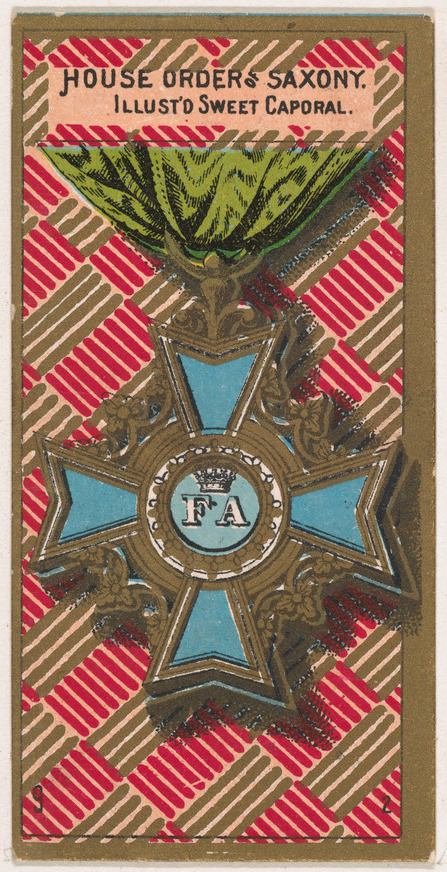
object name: print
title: House Order of Saxony, from the Military Series (N224) issued by Kinney Tobacco Company to promote Sweet Caporal Cigarettes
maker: kinney brothers tobacco company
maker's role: publisher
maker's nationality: american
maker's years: 1869-2011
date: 1888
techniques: color lithograph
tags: military